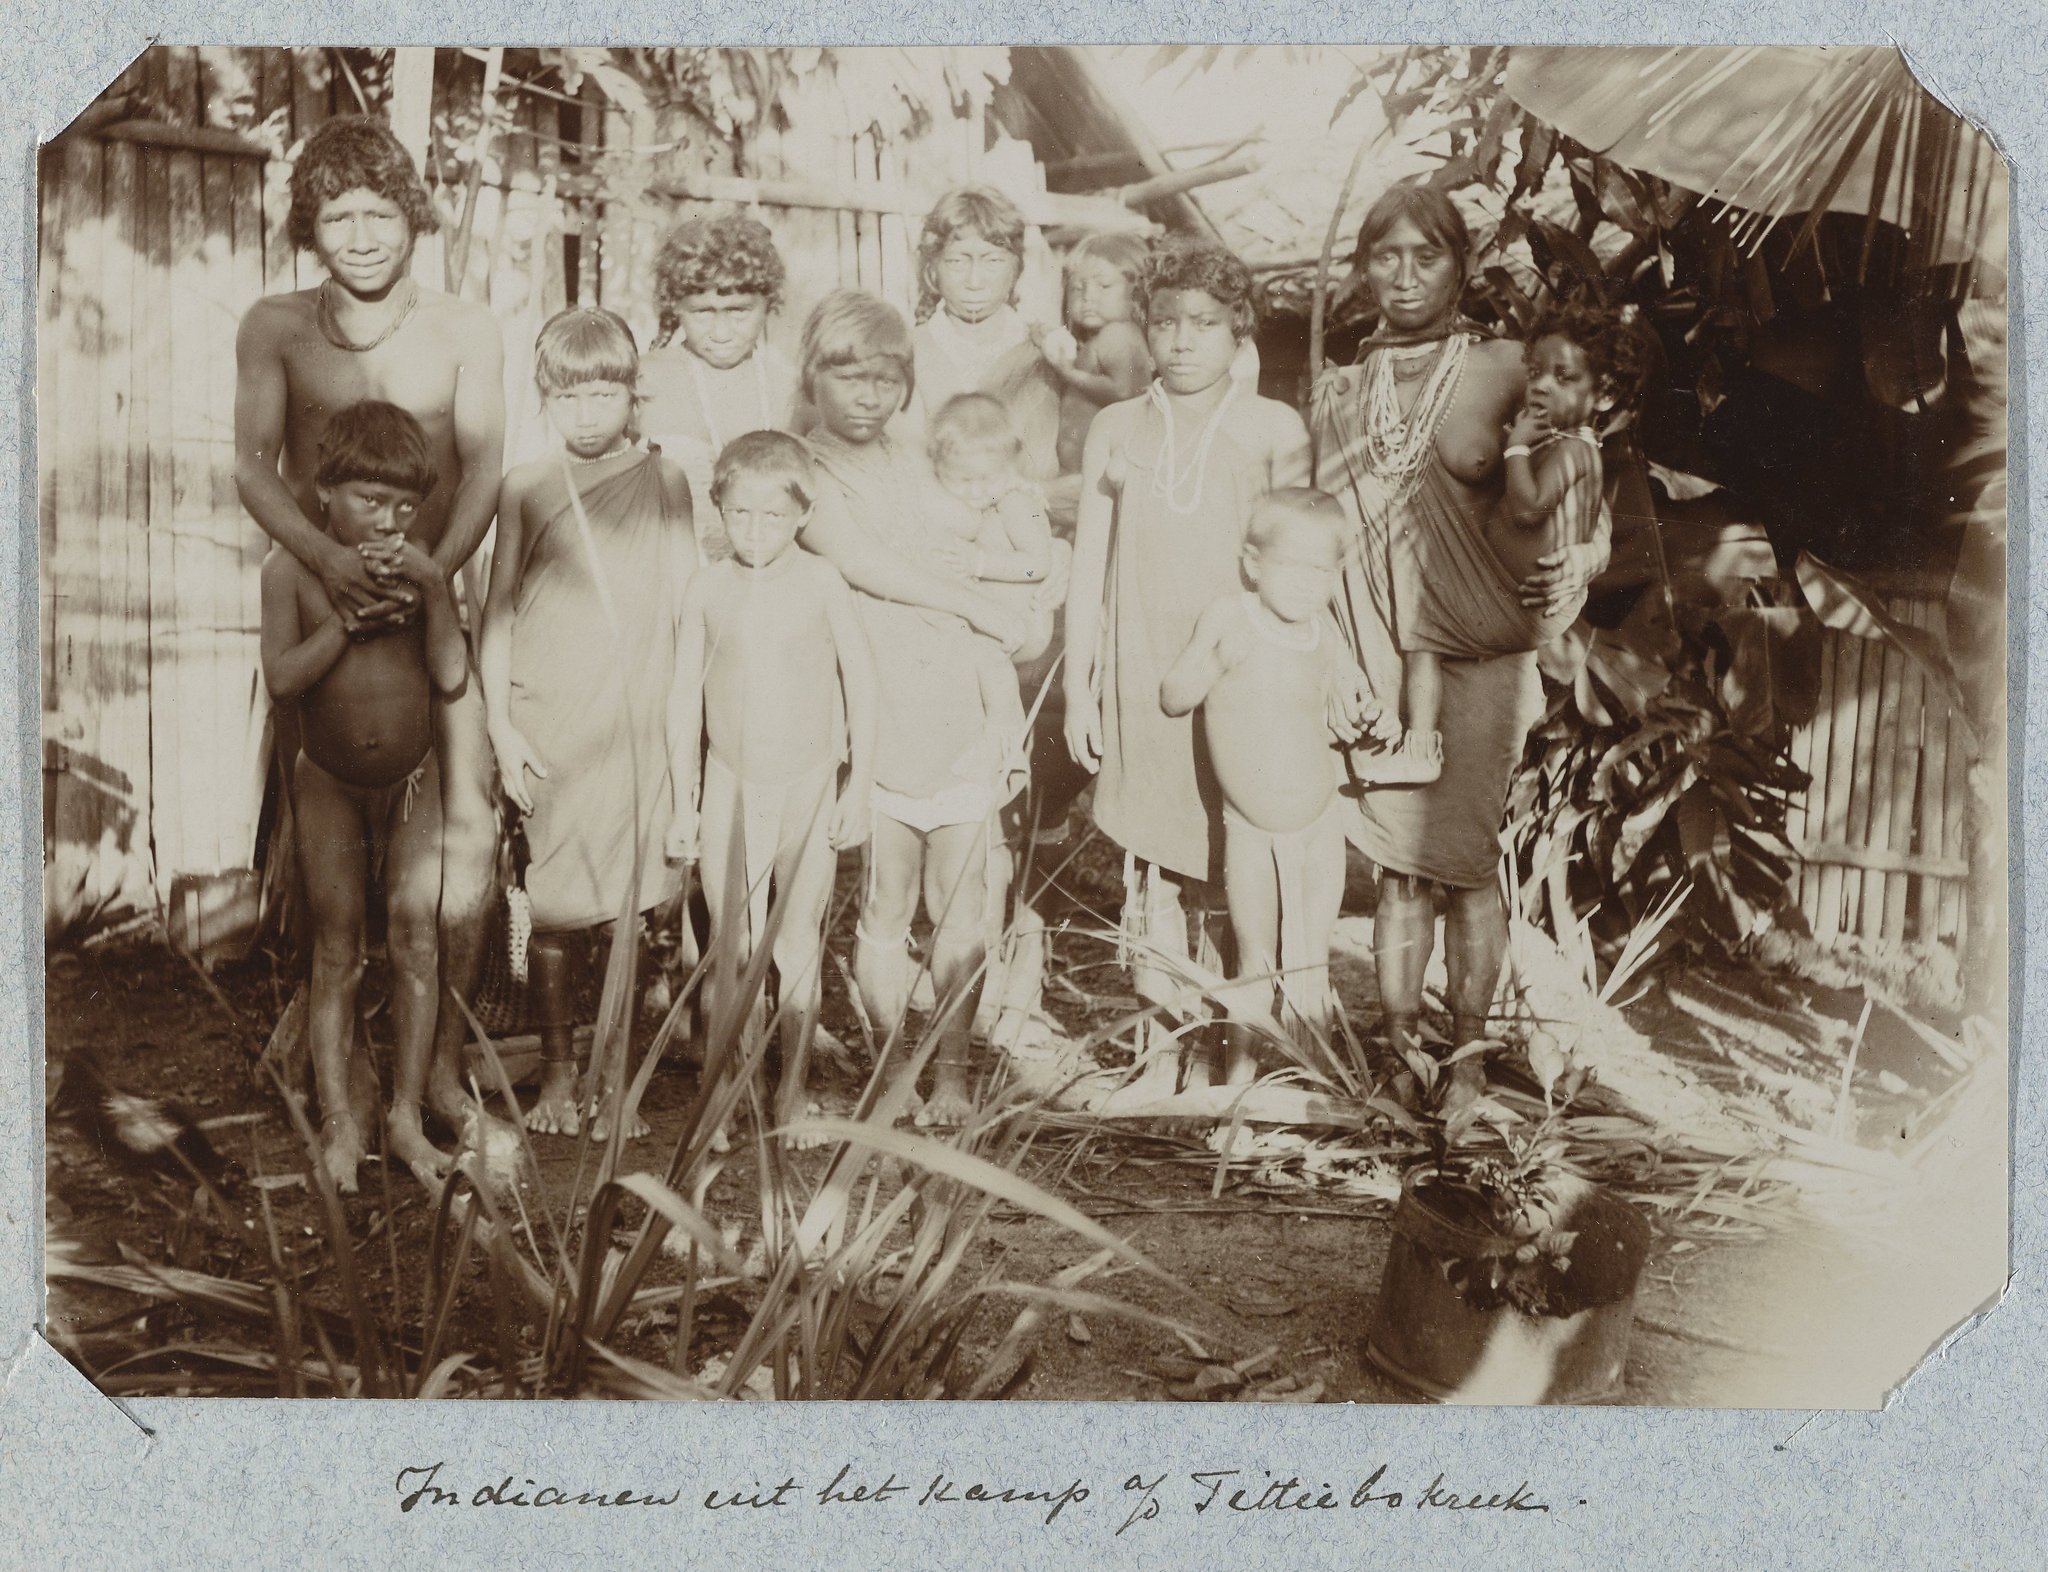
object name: photograph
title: Groepsportret van bewoners van een dorp aan de Tittiebo-kreek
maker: théodore van lelyveld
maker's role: painter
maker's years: 1867-1954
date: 1895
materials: photographic support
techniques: collodion silver print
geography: suriname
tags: indigenous peoples of south america, suriname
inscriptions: inscription: ‘Indianen uit het kamp a/d Tittiebo-kreek’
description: Groepsportret van bewoners van een dorp aan de Tittiebo-kreek (Mauritie Kreek) bij de Wayombo Rivier, tijdens een bezoek met de gouverneur op 6 augustus 1895. Voornamelijk kinderen en enkele vrouwen met baby’s. In het dorp wonen nazaten van de oorspronkelijke bewoners van Suriname. Fotoafdruk in een fotoalbum van Théodore van Lelyveld over Suriname uit 1895-1898.